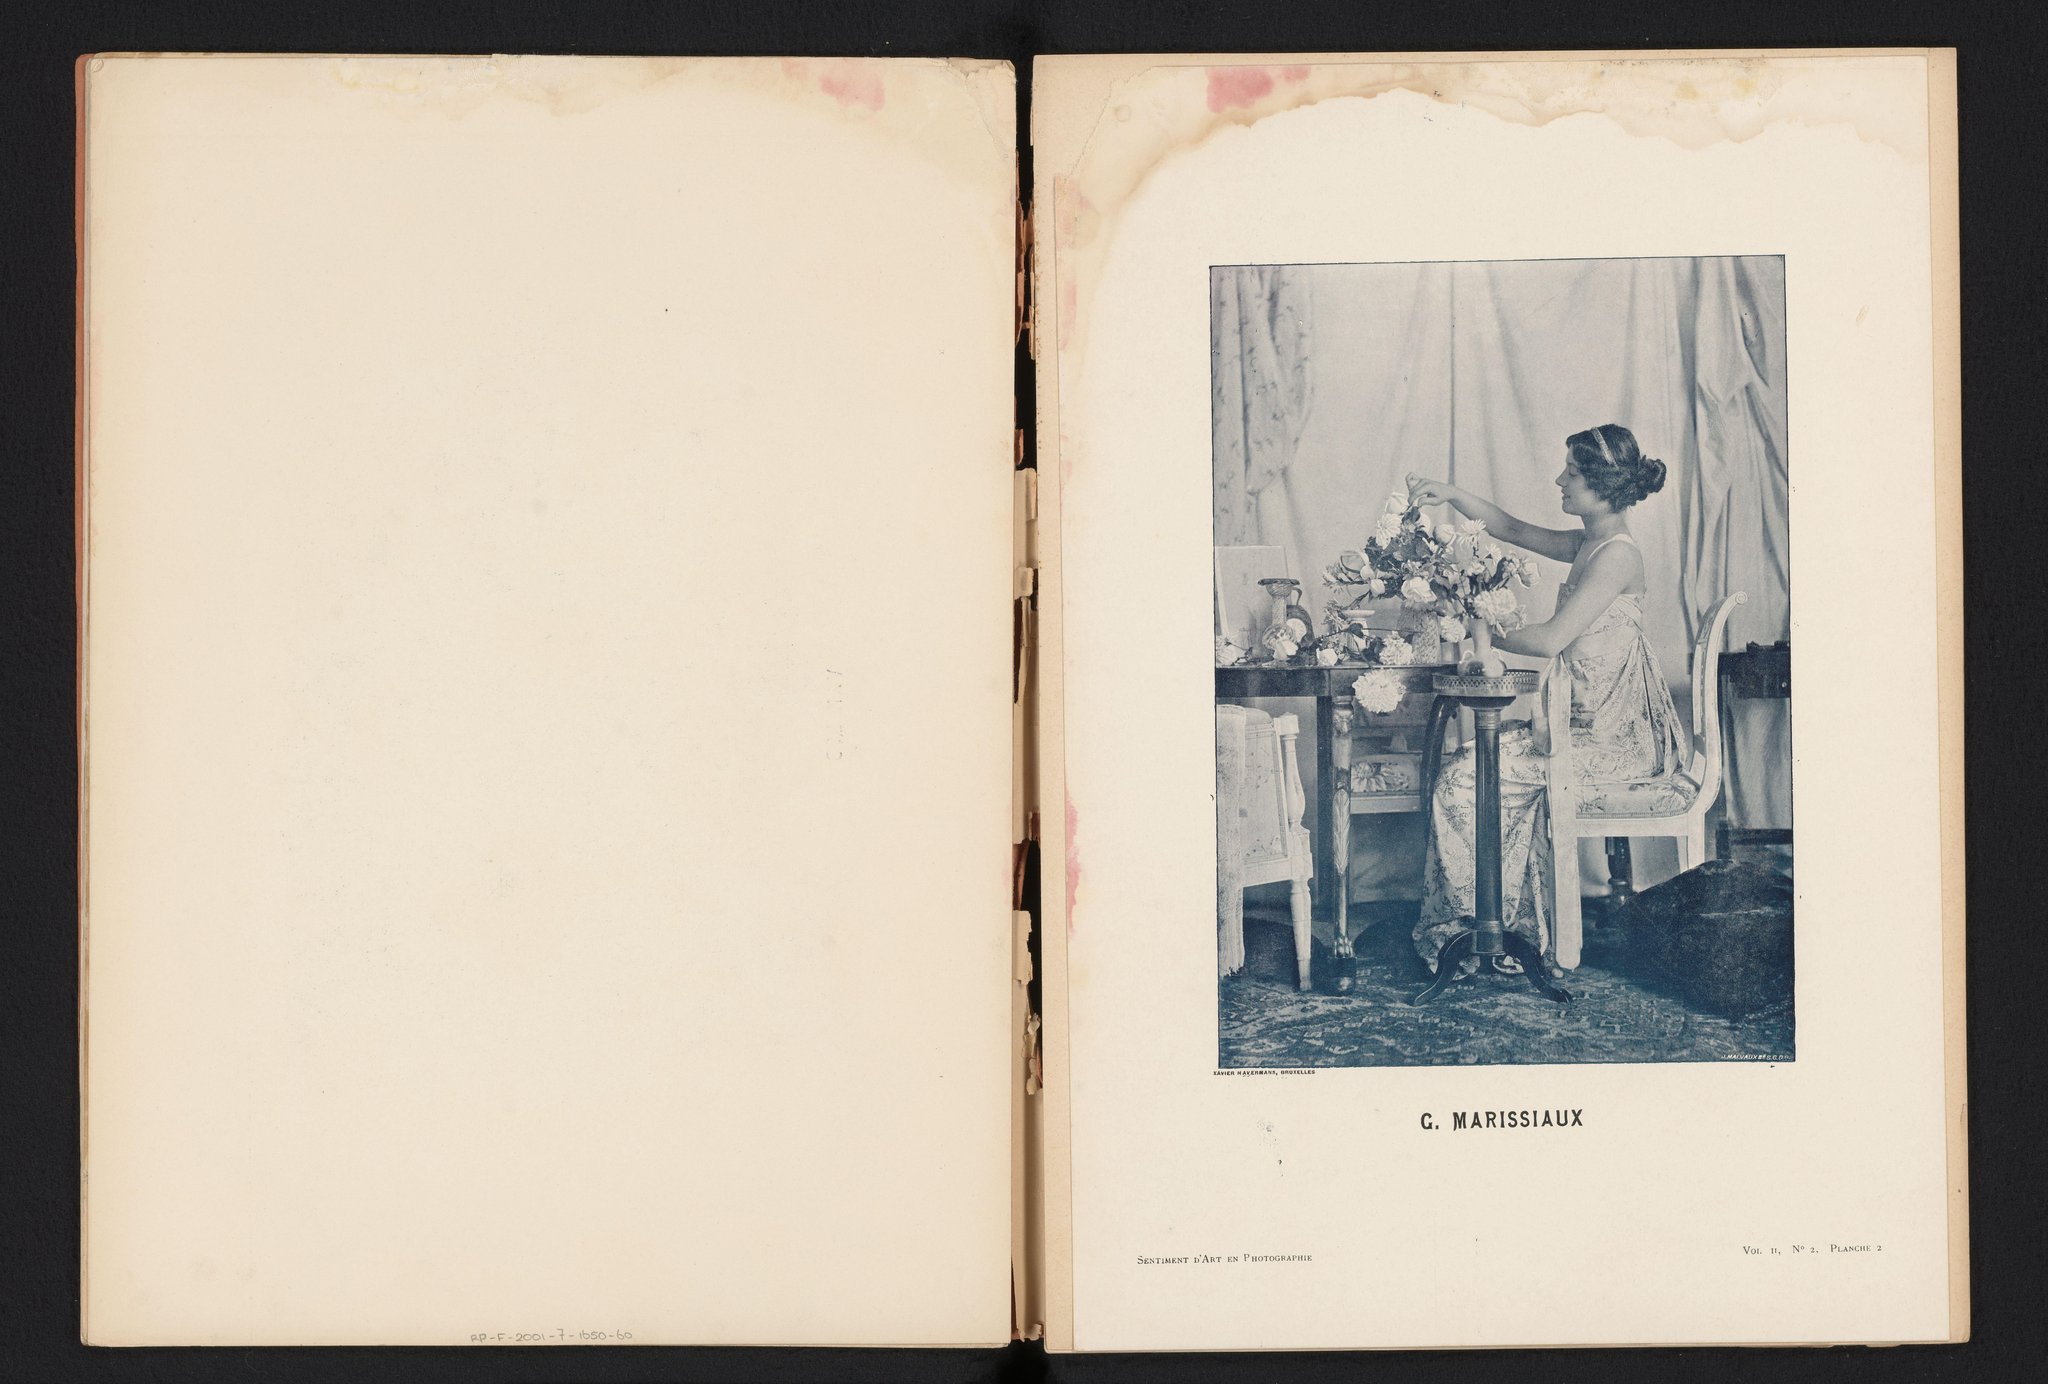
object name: photomechanical print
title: Vrouw maakt een bloemstuk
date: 1895-1900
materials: paper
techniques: autotype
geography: brussels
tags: adult woman, arranging flowers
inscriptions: number: ‘Vol. II, No 2, Planche 2.’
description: Deze prent maakt deel uit van 8 omslagen met 22 tekstbladen en 89 prenten op losse bladen in en tussen de omslagen.